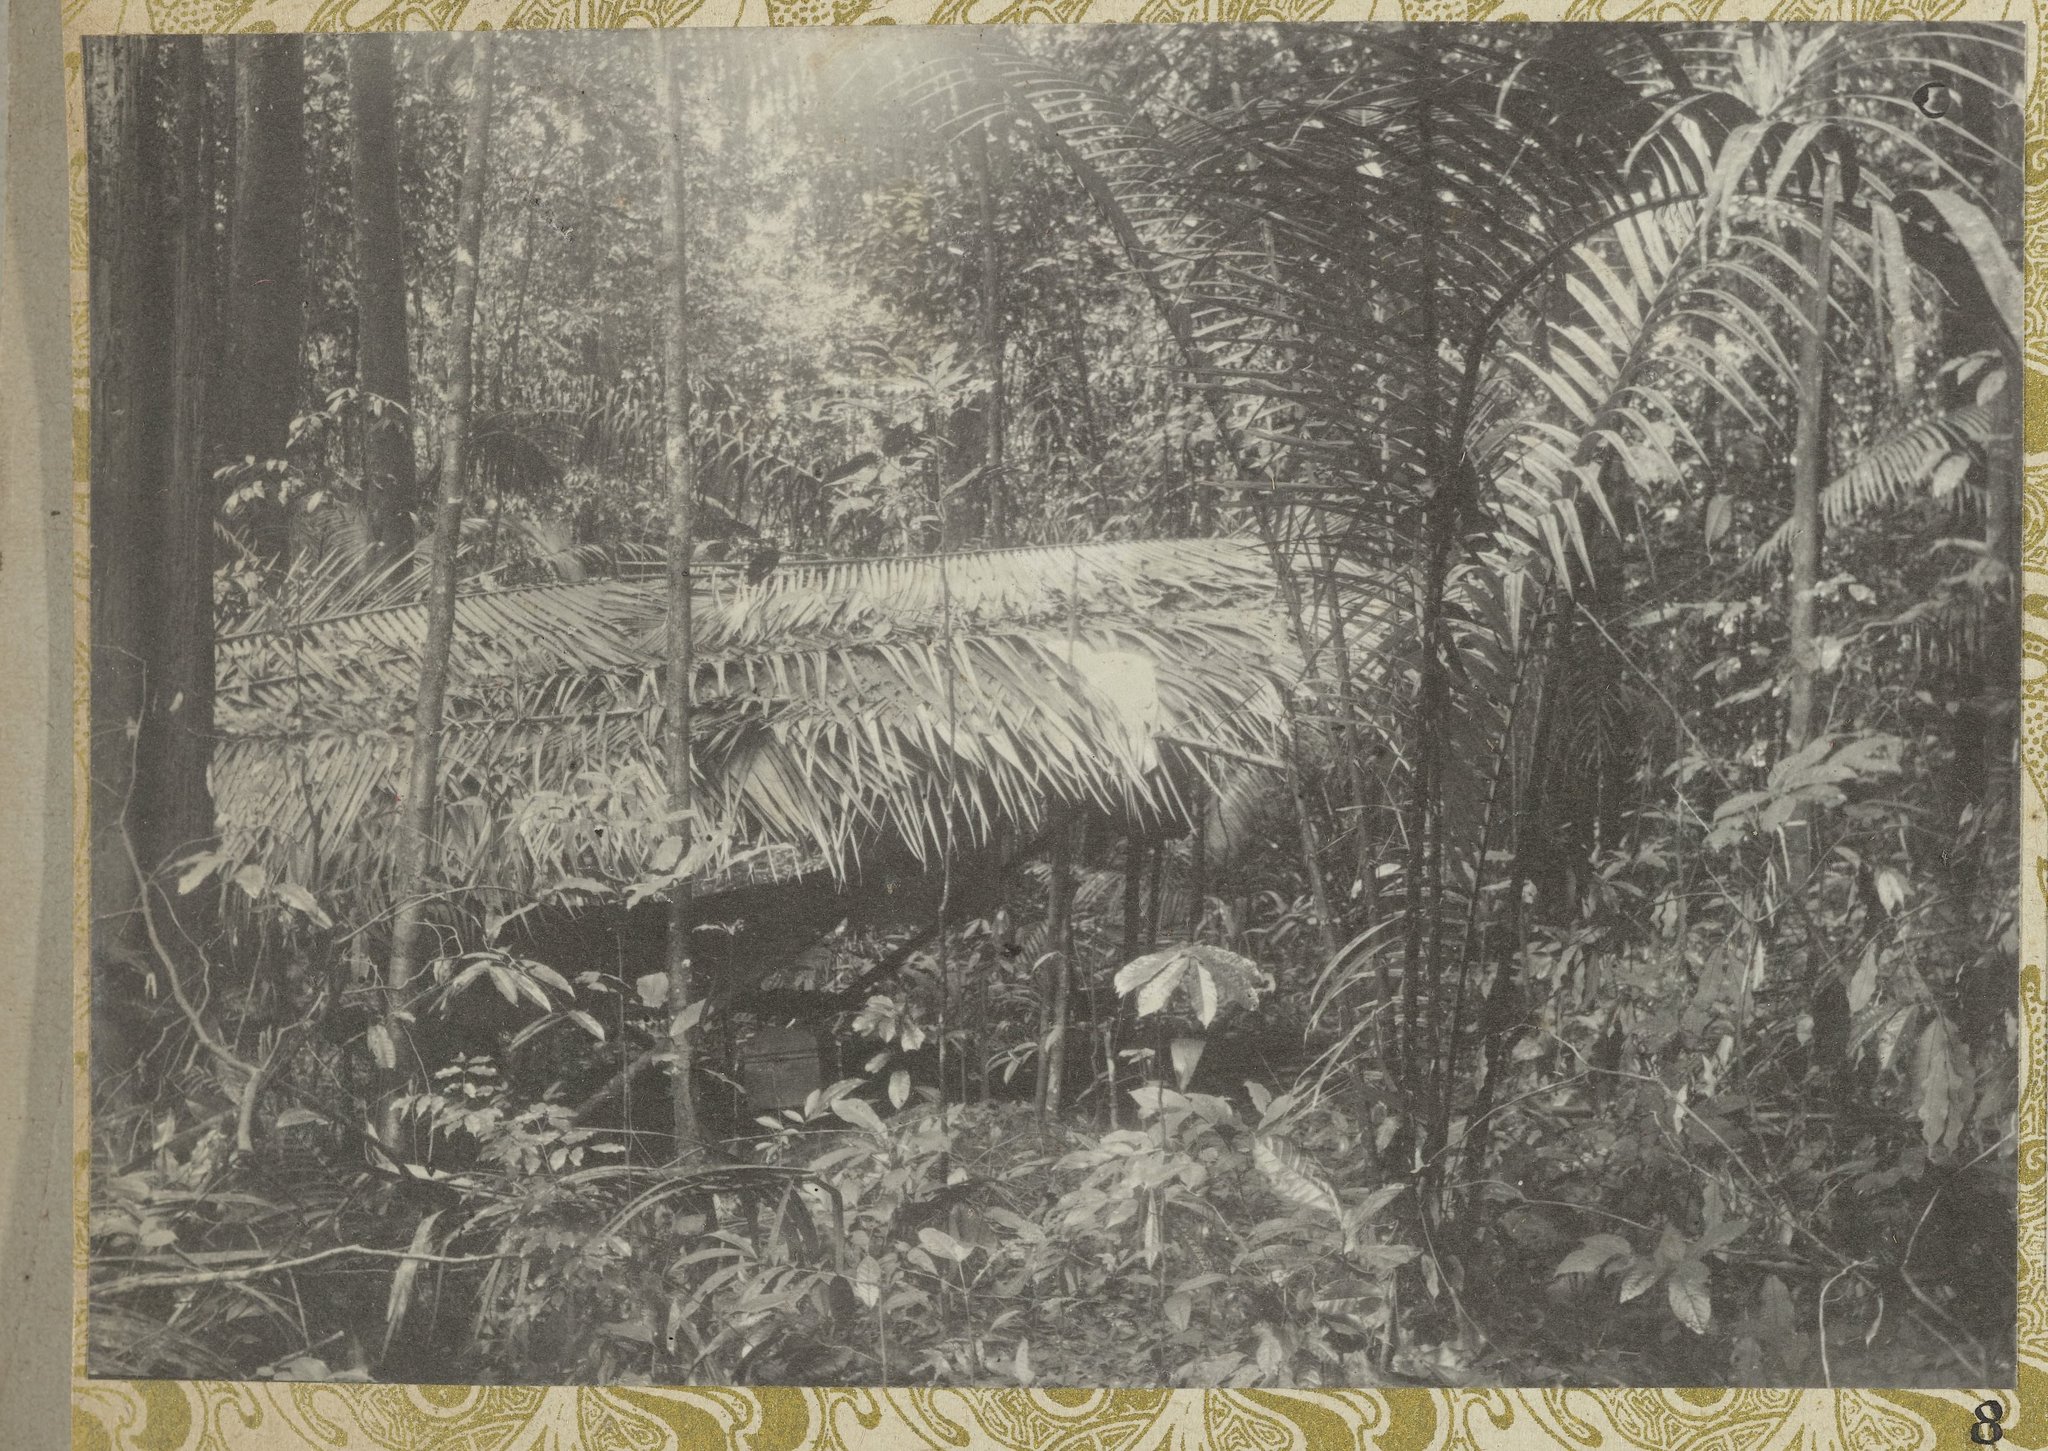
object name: photograph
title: Meetkamp in oerbosch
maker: hendrik doijer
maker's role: engineer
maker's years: 1863-1925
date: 1903-1910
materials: photographic support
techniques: gelatin silver print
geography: suriname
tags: suriname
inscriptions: inscription: ‘8’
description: Gezicht op een hut gebouwd van takken en bladeren in het meetkamp, in het oerwoud. Onderdeel van het fotoalbum Souvenir de Voyage (deel 1), over het leven van de familie Doijer in en rond de plantage Ma Retraite in Suriname in de jaren 1903-1910.